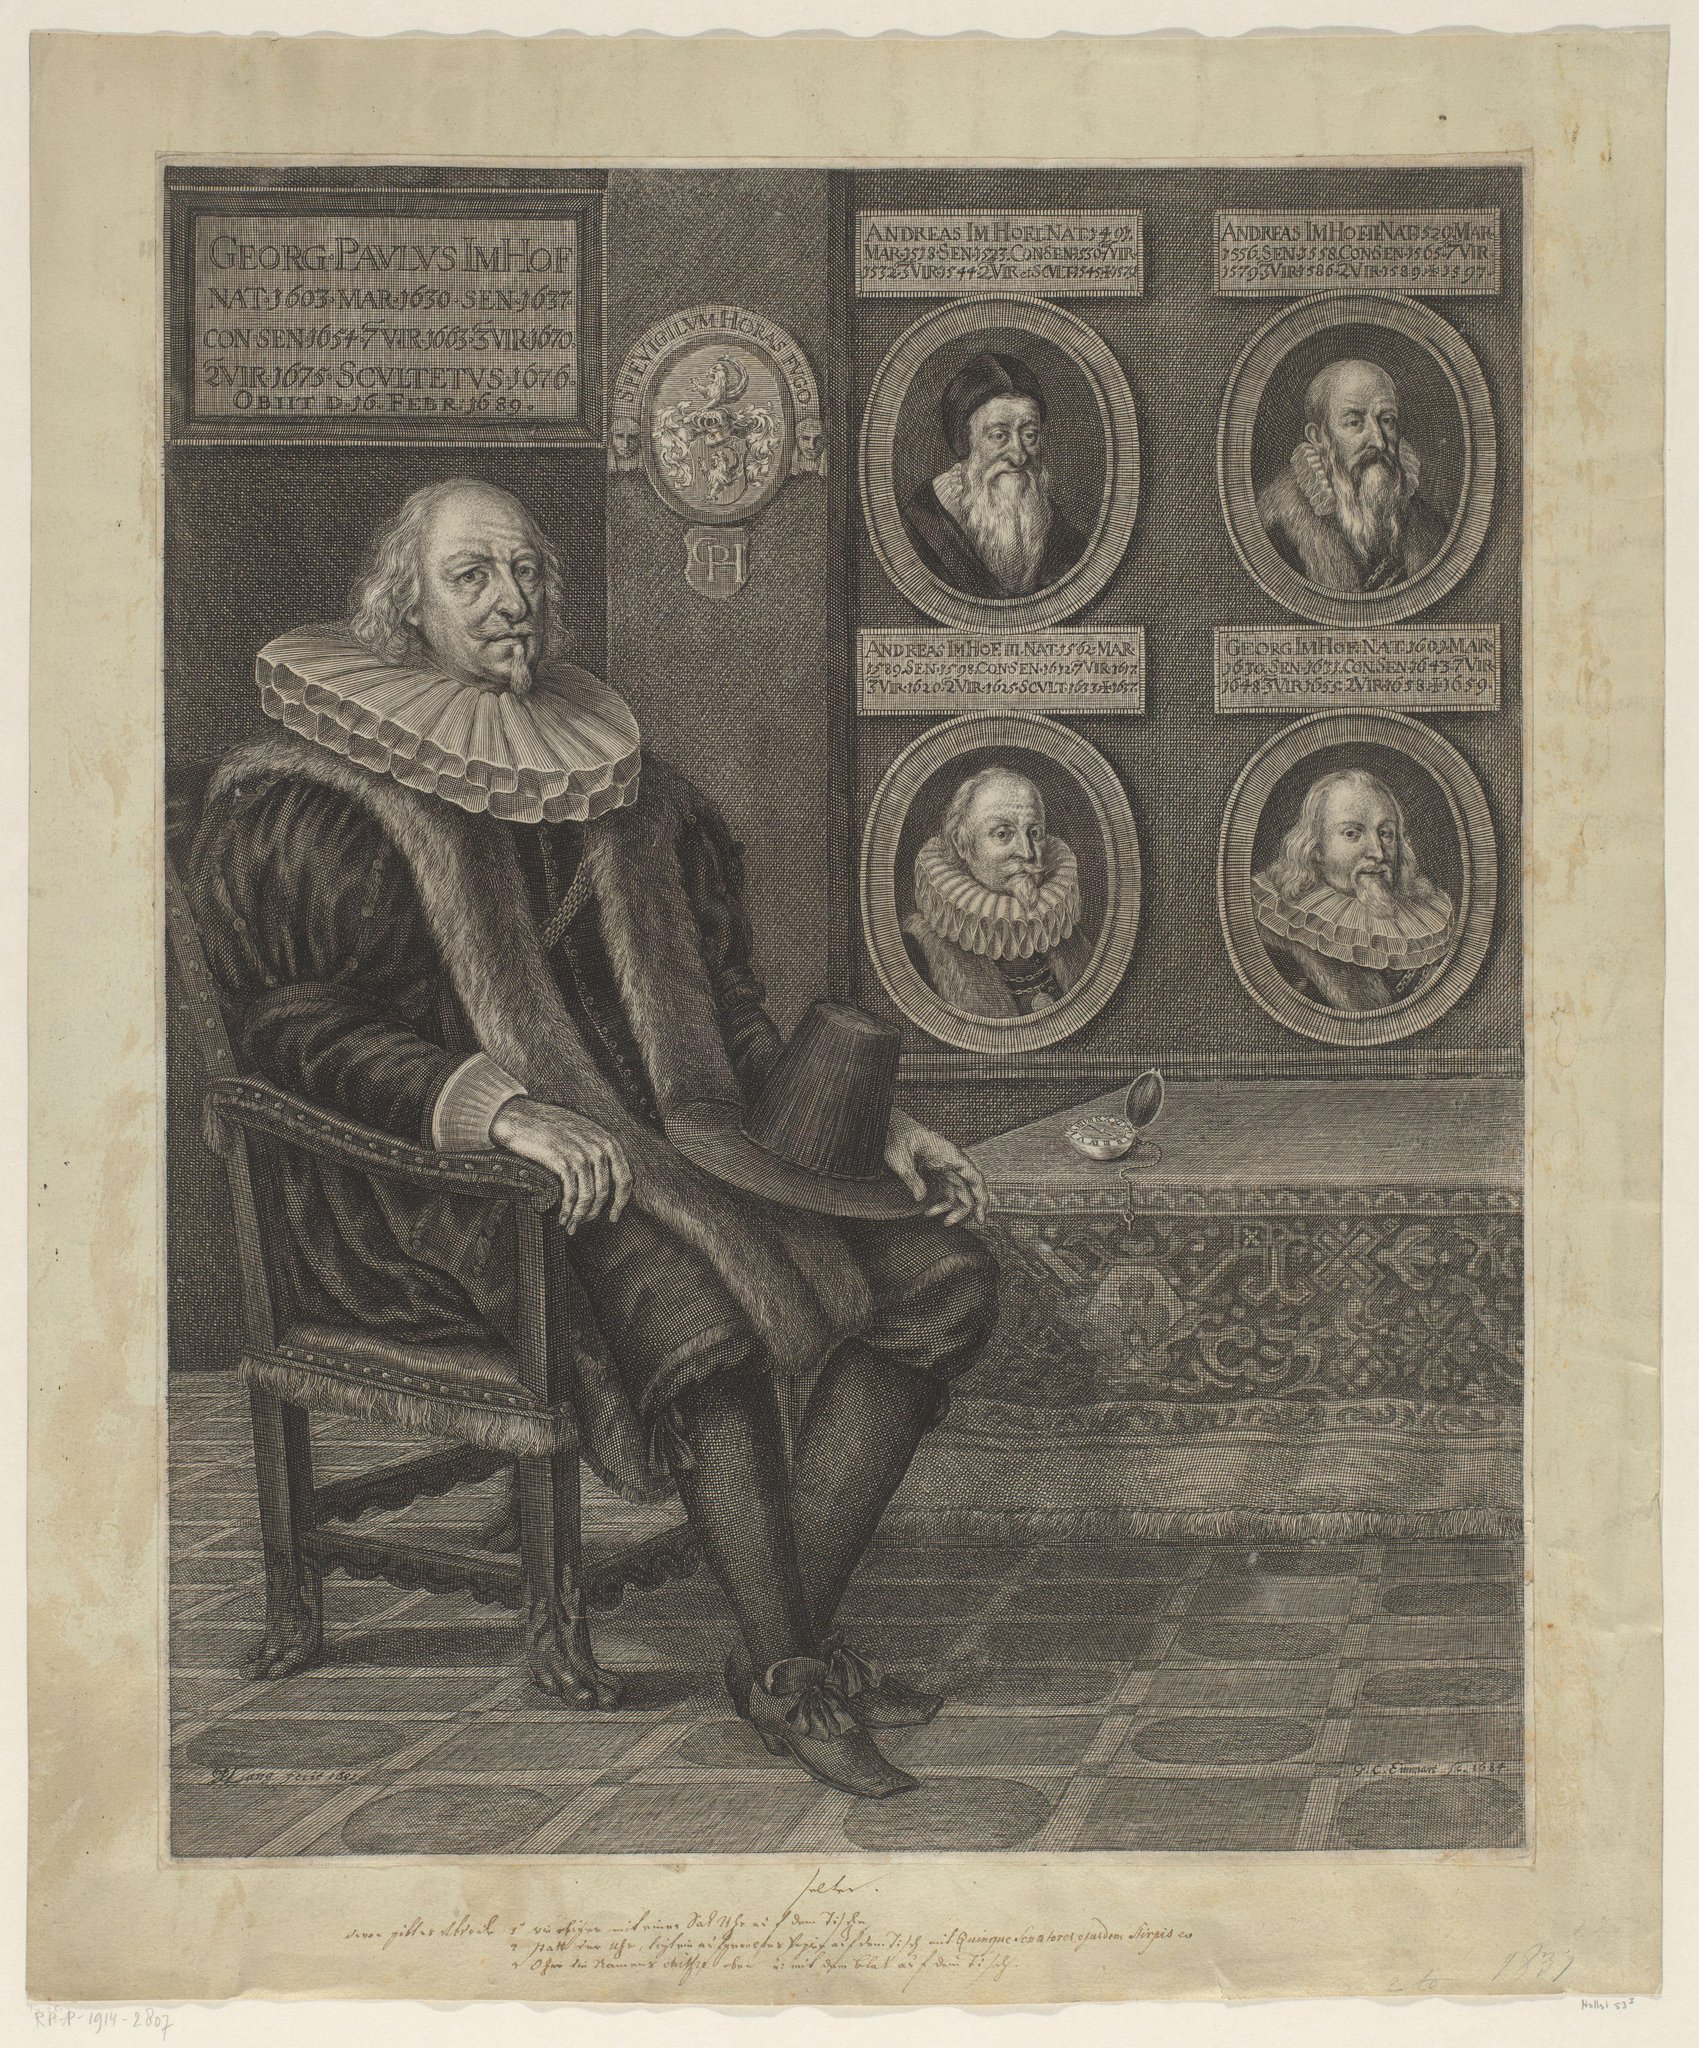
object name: print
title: Portret van raadslid Georg Paulus Imhoff, zittend voor de portretten van zijn voorgangers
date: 1682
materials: paper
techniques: engraving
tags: mayor, head-gear, historical persons, watch, armorial bearing, heraldry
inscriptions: collector's mark: Lugt 2228